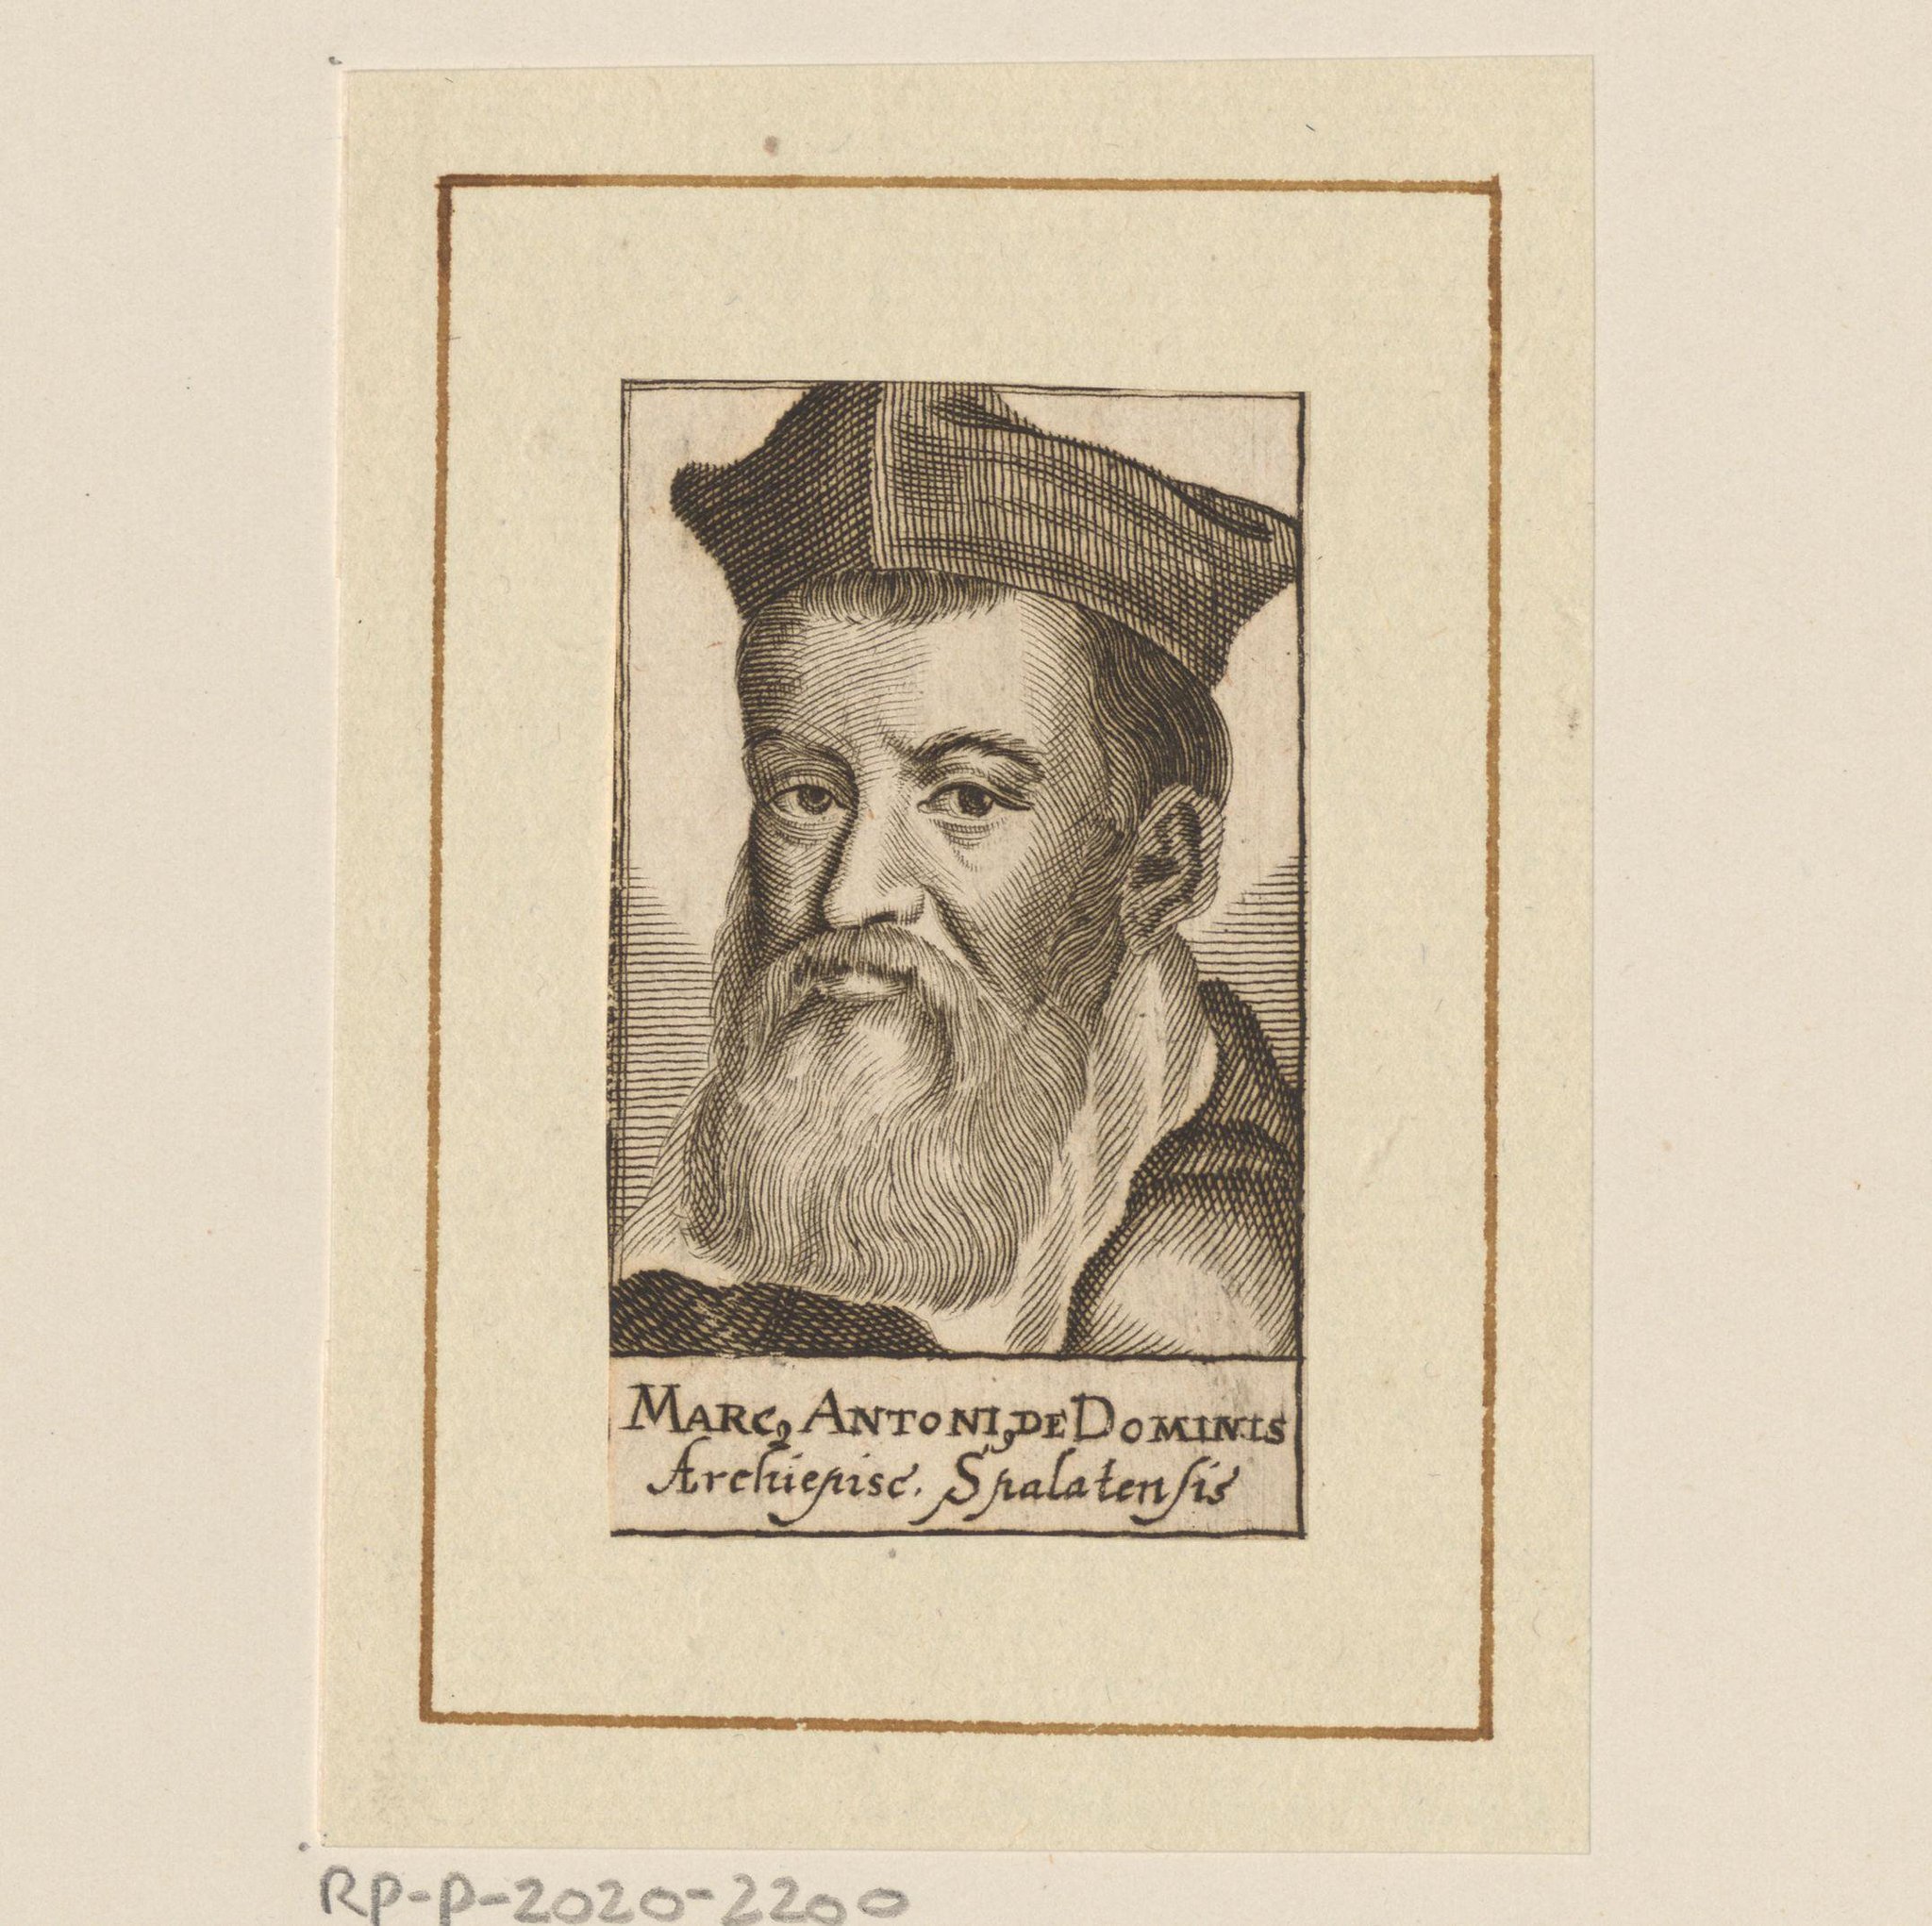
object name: print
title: Portret van Marcus Antonius De Dominis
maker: Anonymous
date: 1688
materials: paper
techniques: engraving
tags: rome, scholar, philosopher, historical persons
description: Prent maakt deel uit van een grotere prent die later is verknipt. Prent waarschijnlijk uit: Freher, Paul. Theatrum virorum eruditione clarorum. Neurenberg: Johann Hoffmann, 1688.